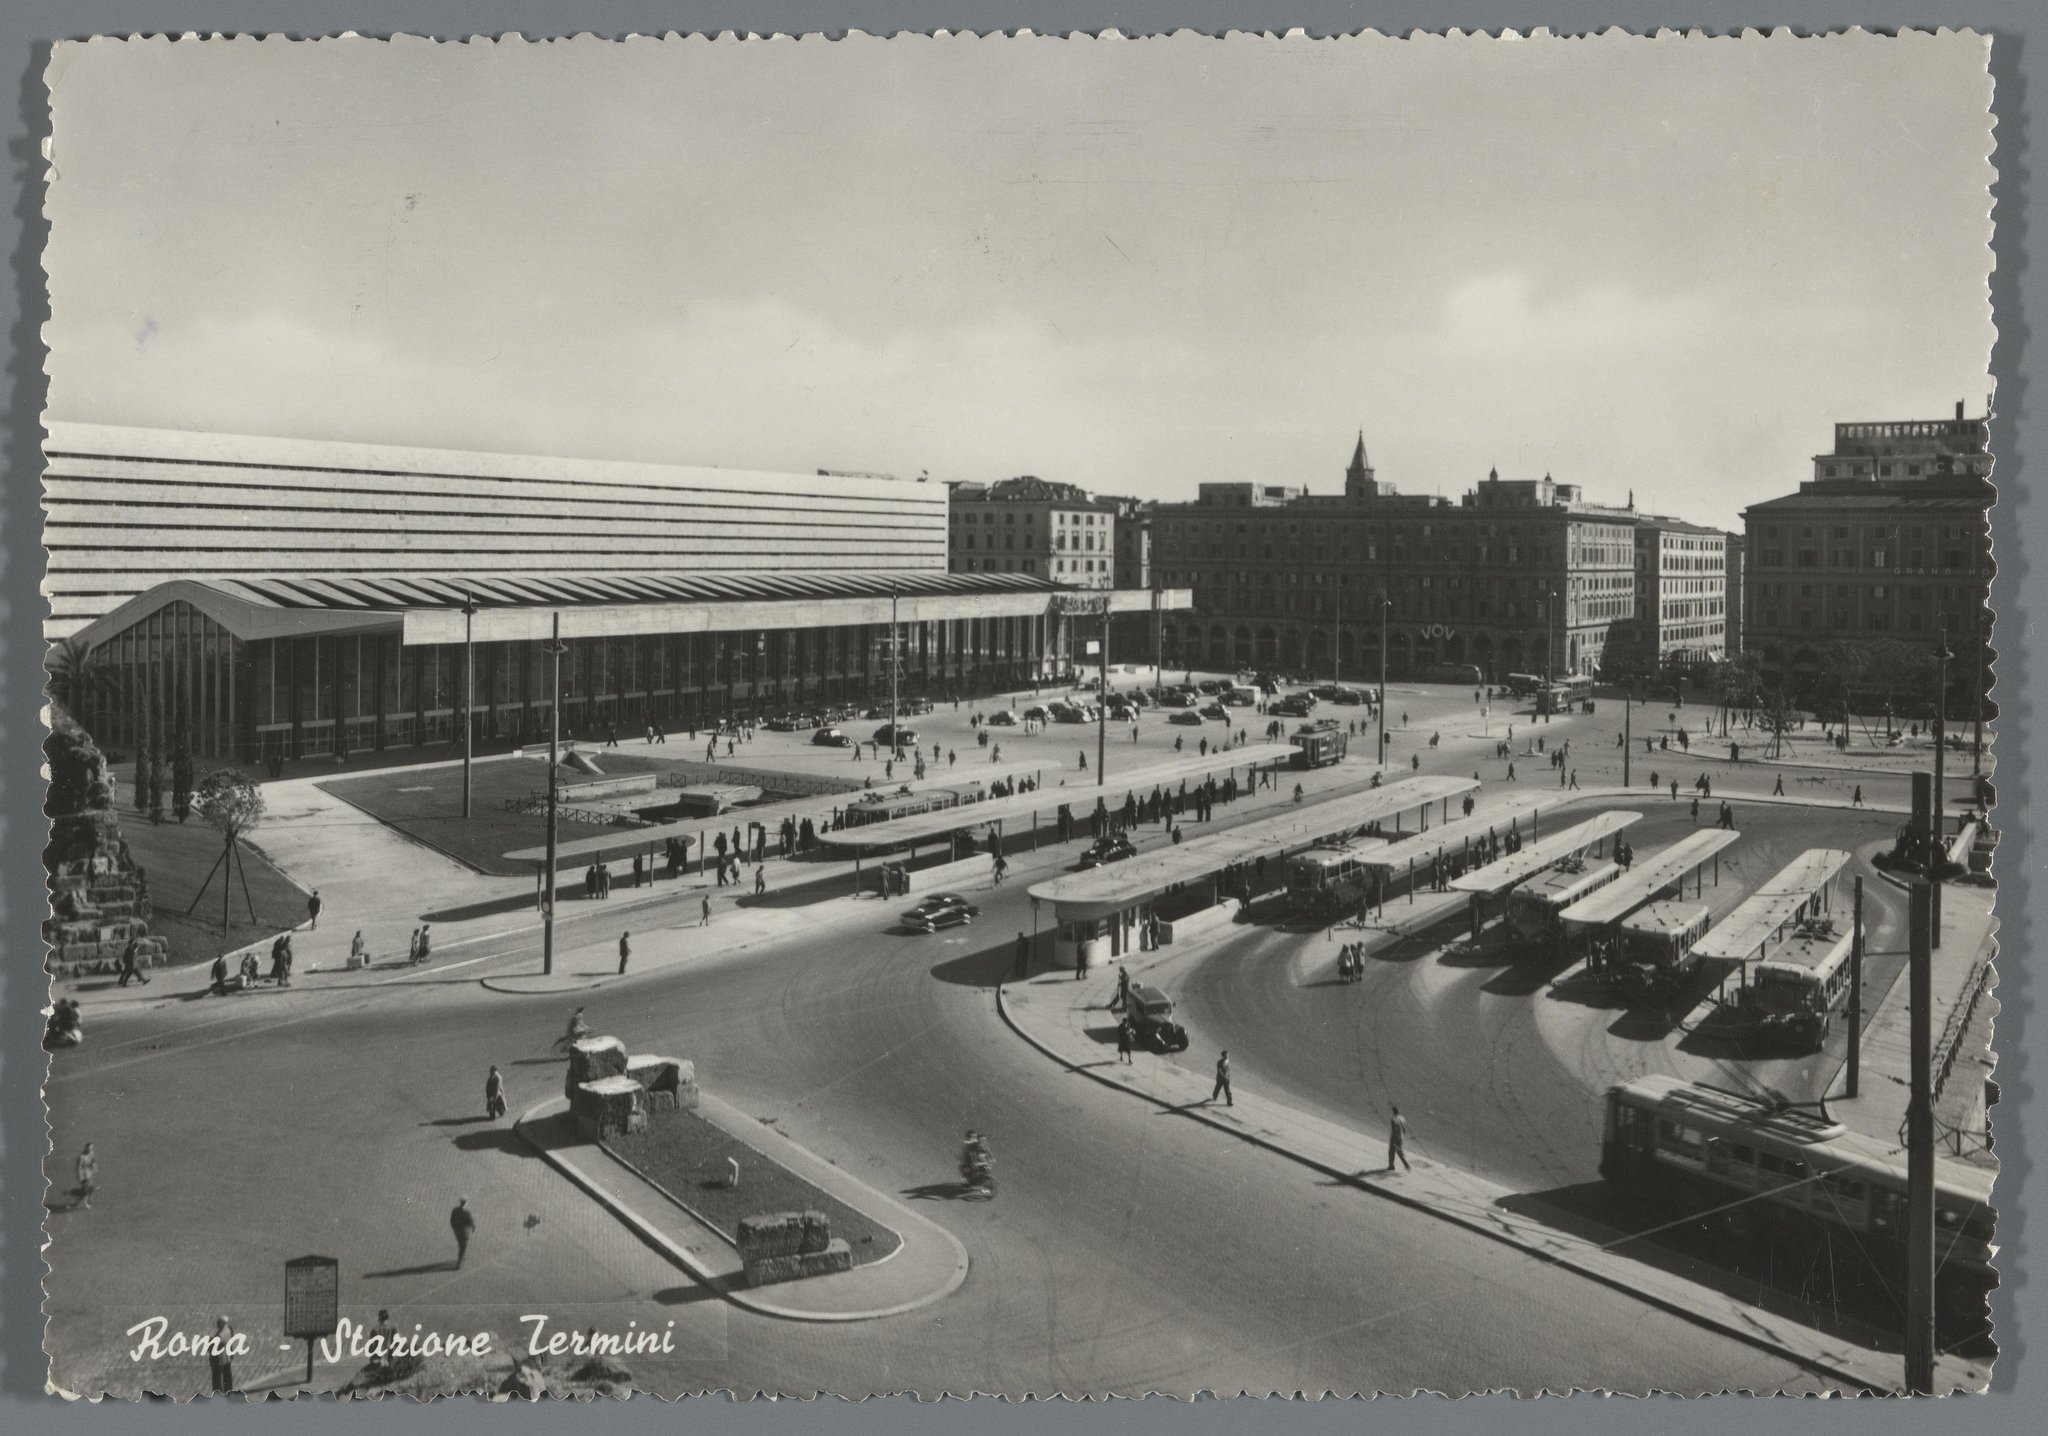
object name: postcard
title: Roma, Stazione Termini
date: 1920-1950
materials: photographic support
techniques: gelatin silver print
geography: turin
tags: stazione termini